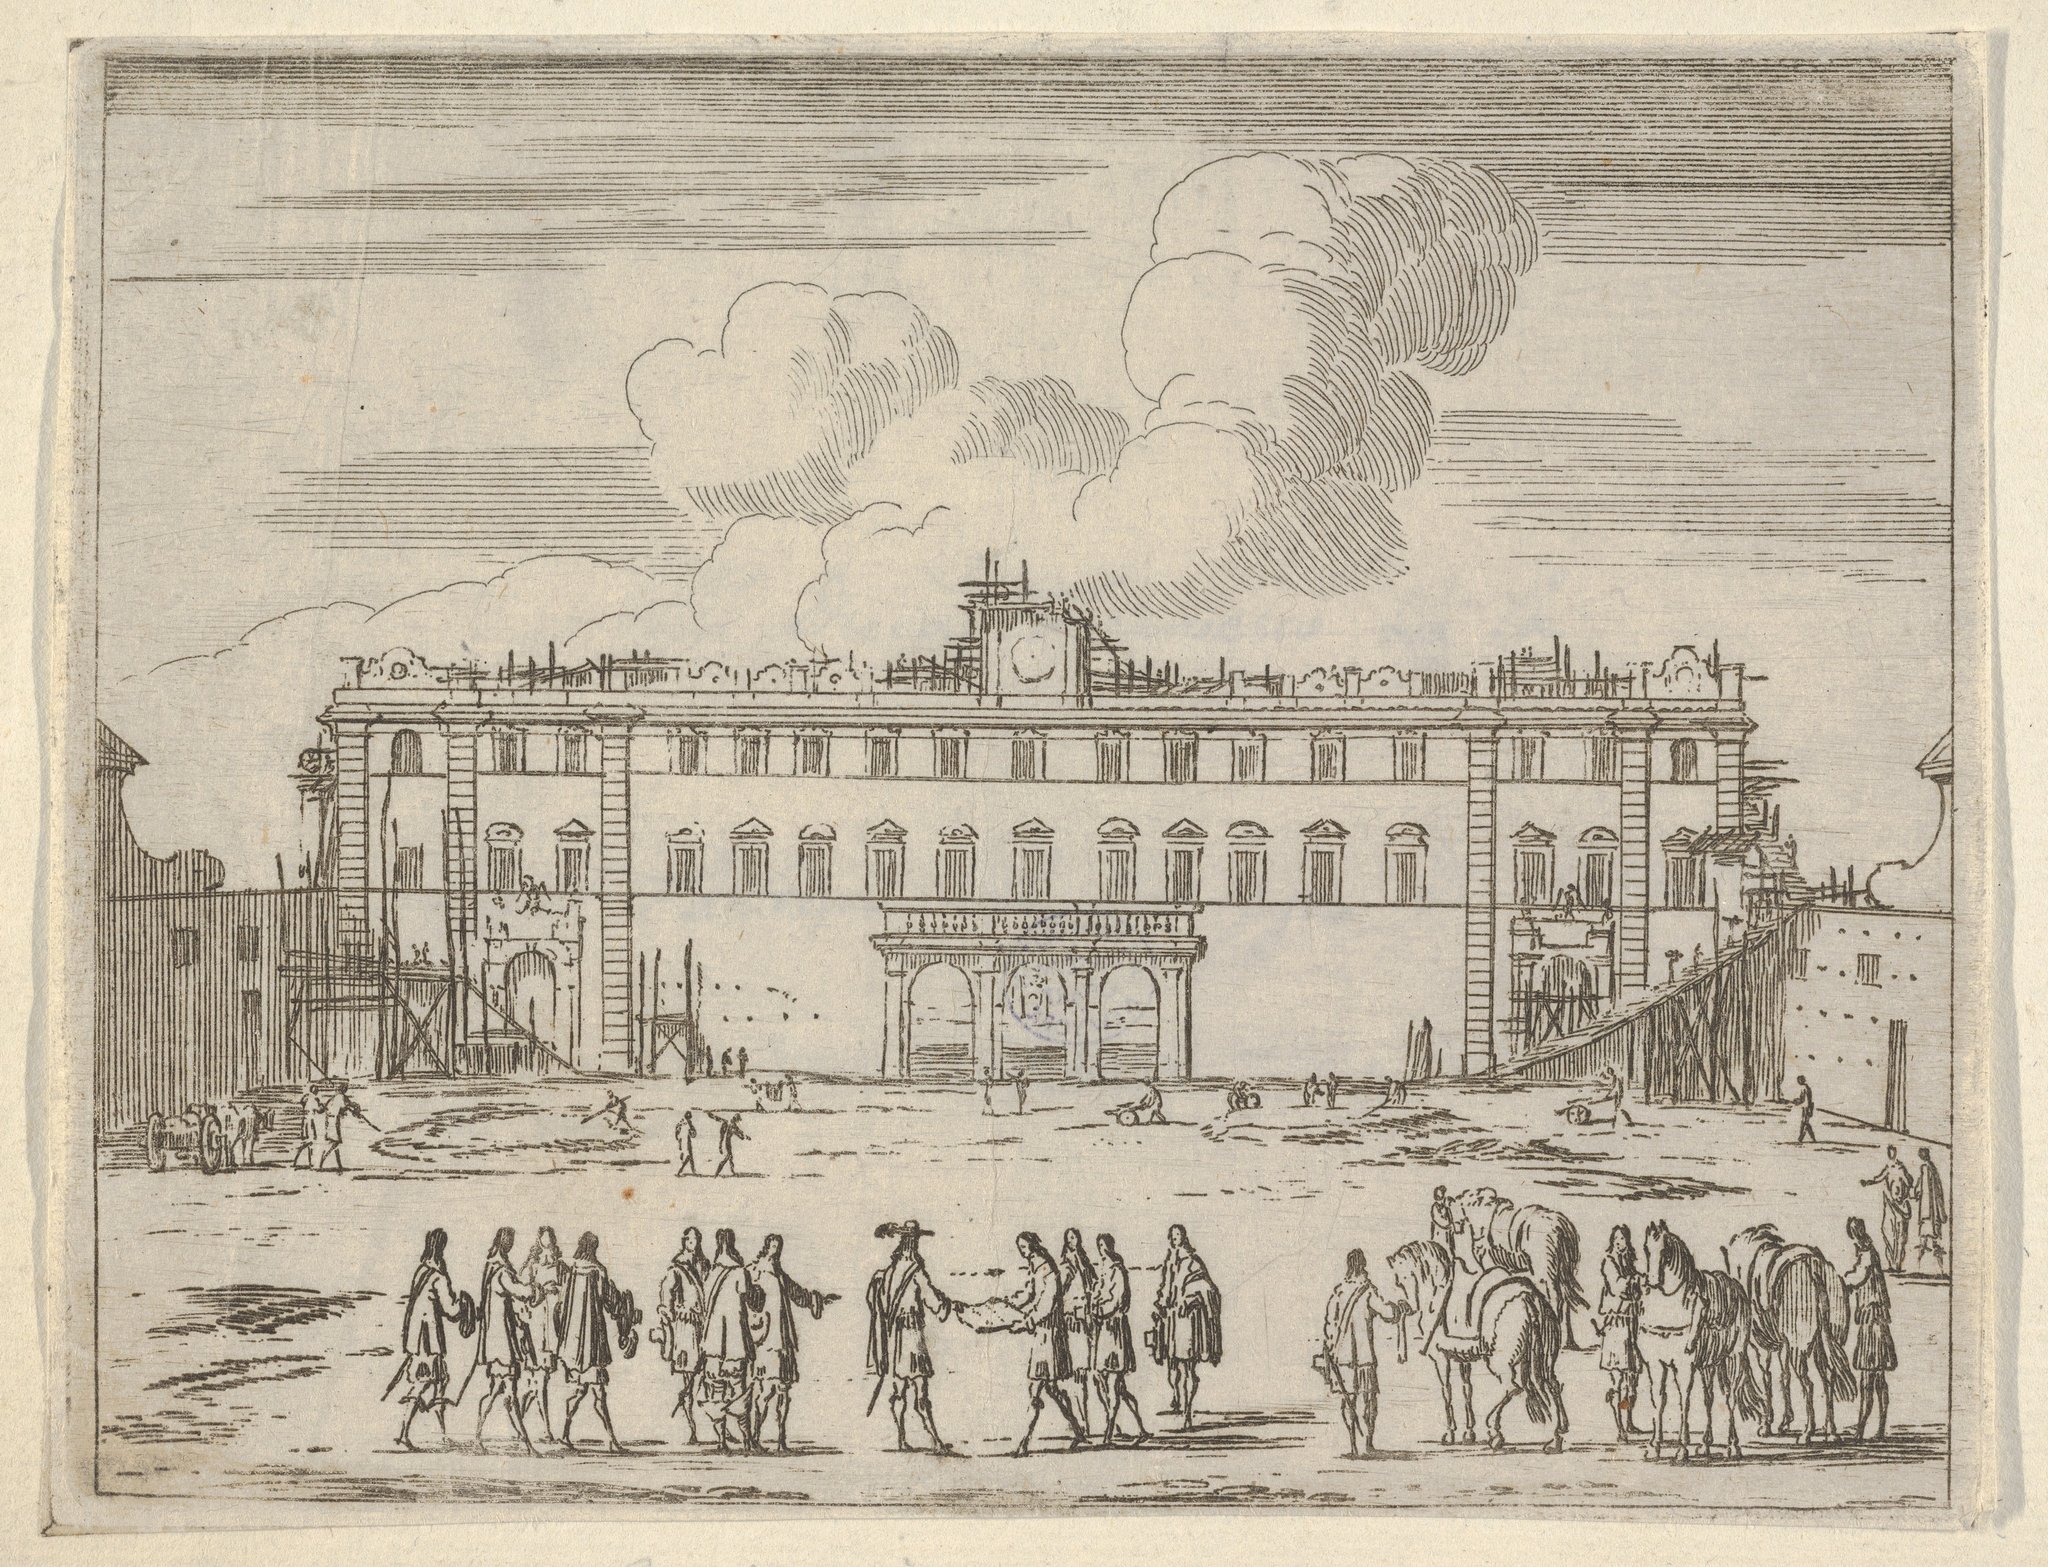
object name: print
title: Francesco I d'Este Builds the Palazzo di Sassuolo, from "L'Idea di un Principe ed Eroe Cristiano in Francesco I d'Este, di Modena e Reggio Duca VIII [...]"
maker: bartolomeo fenice (fénis)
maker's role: artist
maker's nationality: italian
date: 1659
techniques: etching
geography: italy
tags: buildings,men